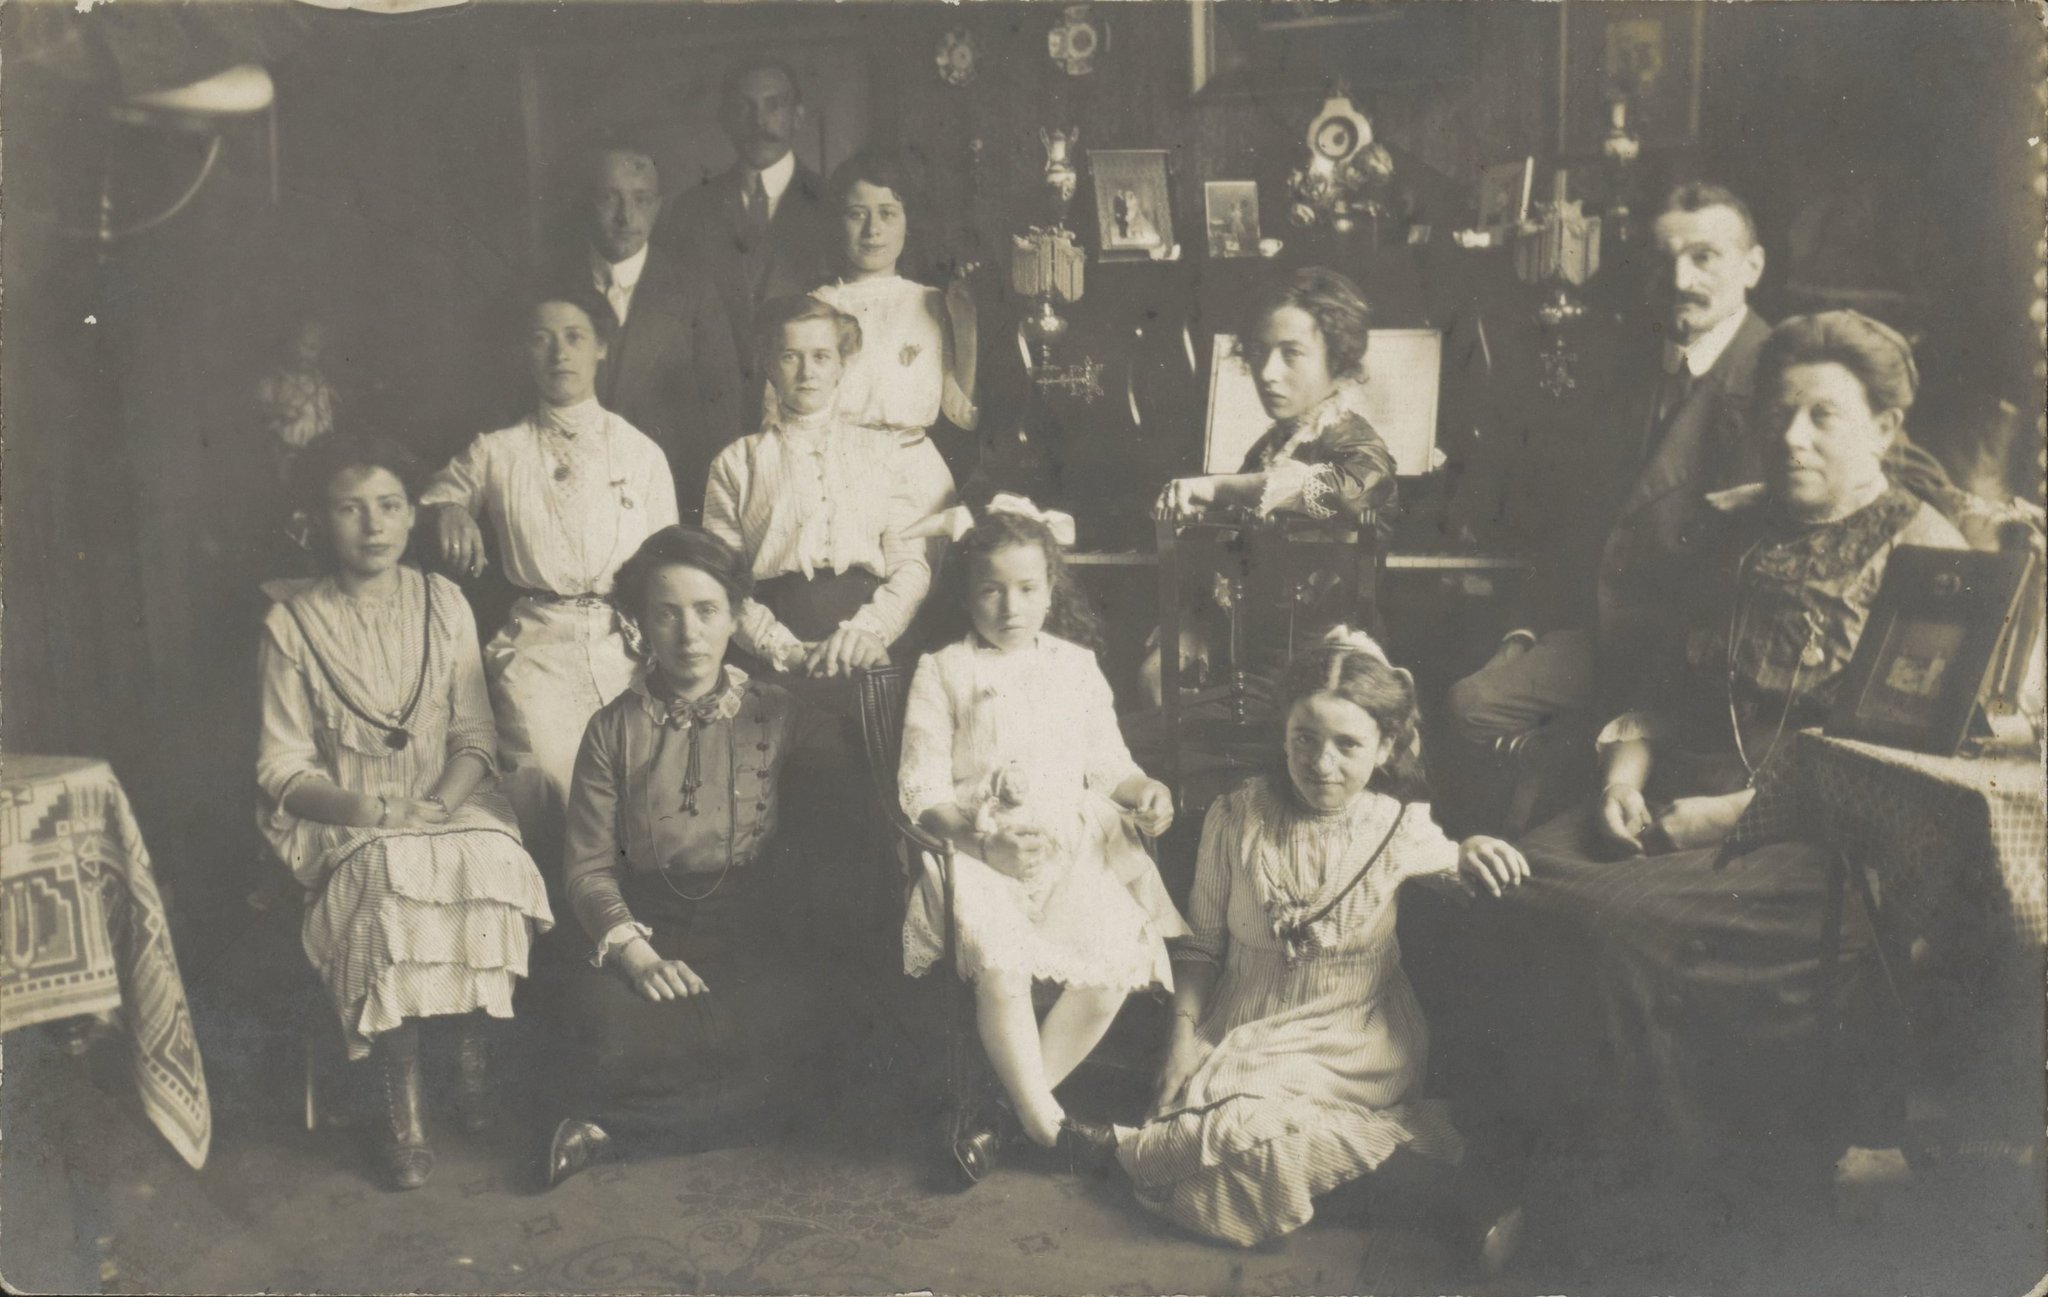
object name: photograph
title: Portret van een familie in een huiskamer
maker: Anonymous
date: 1900-1920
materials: photographic support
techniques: gelatin silver print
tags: three generations (family group)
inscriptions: date: ‘ca. 1900?’